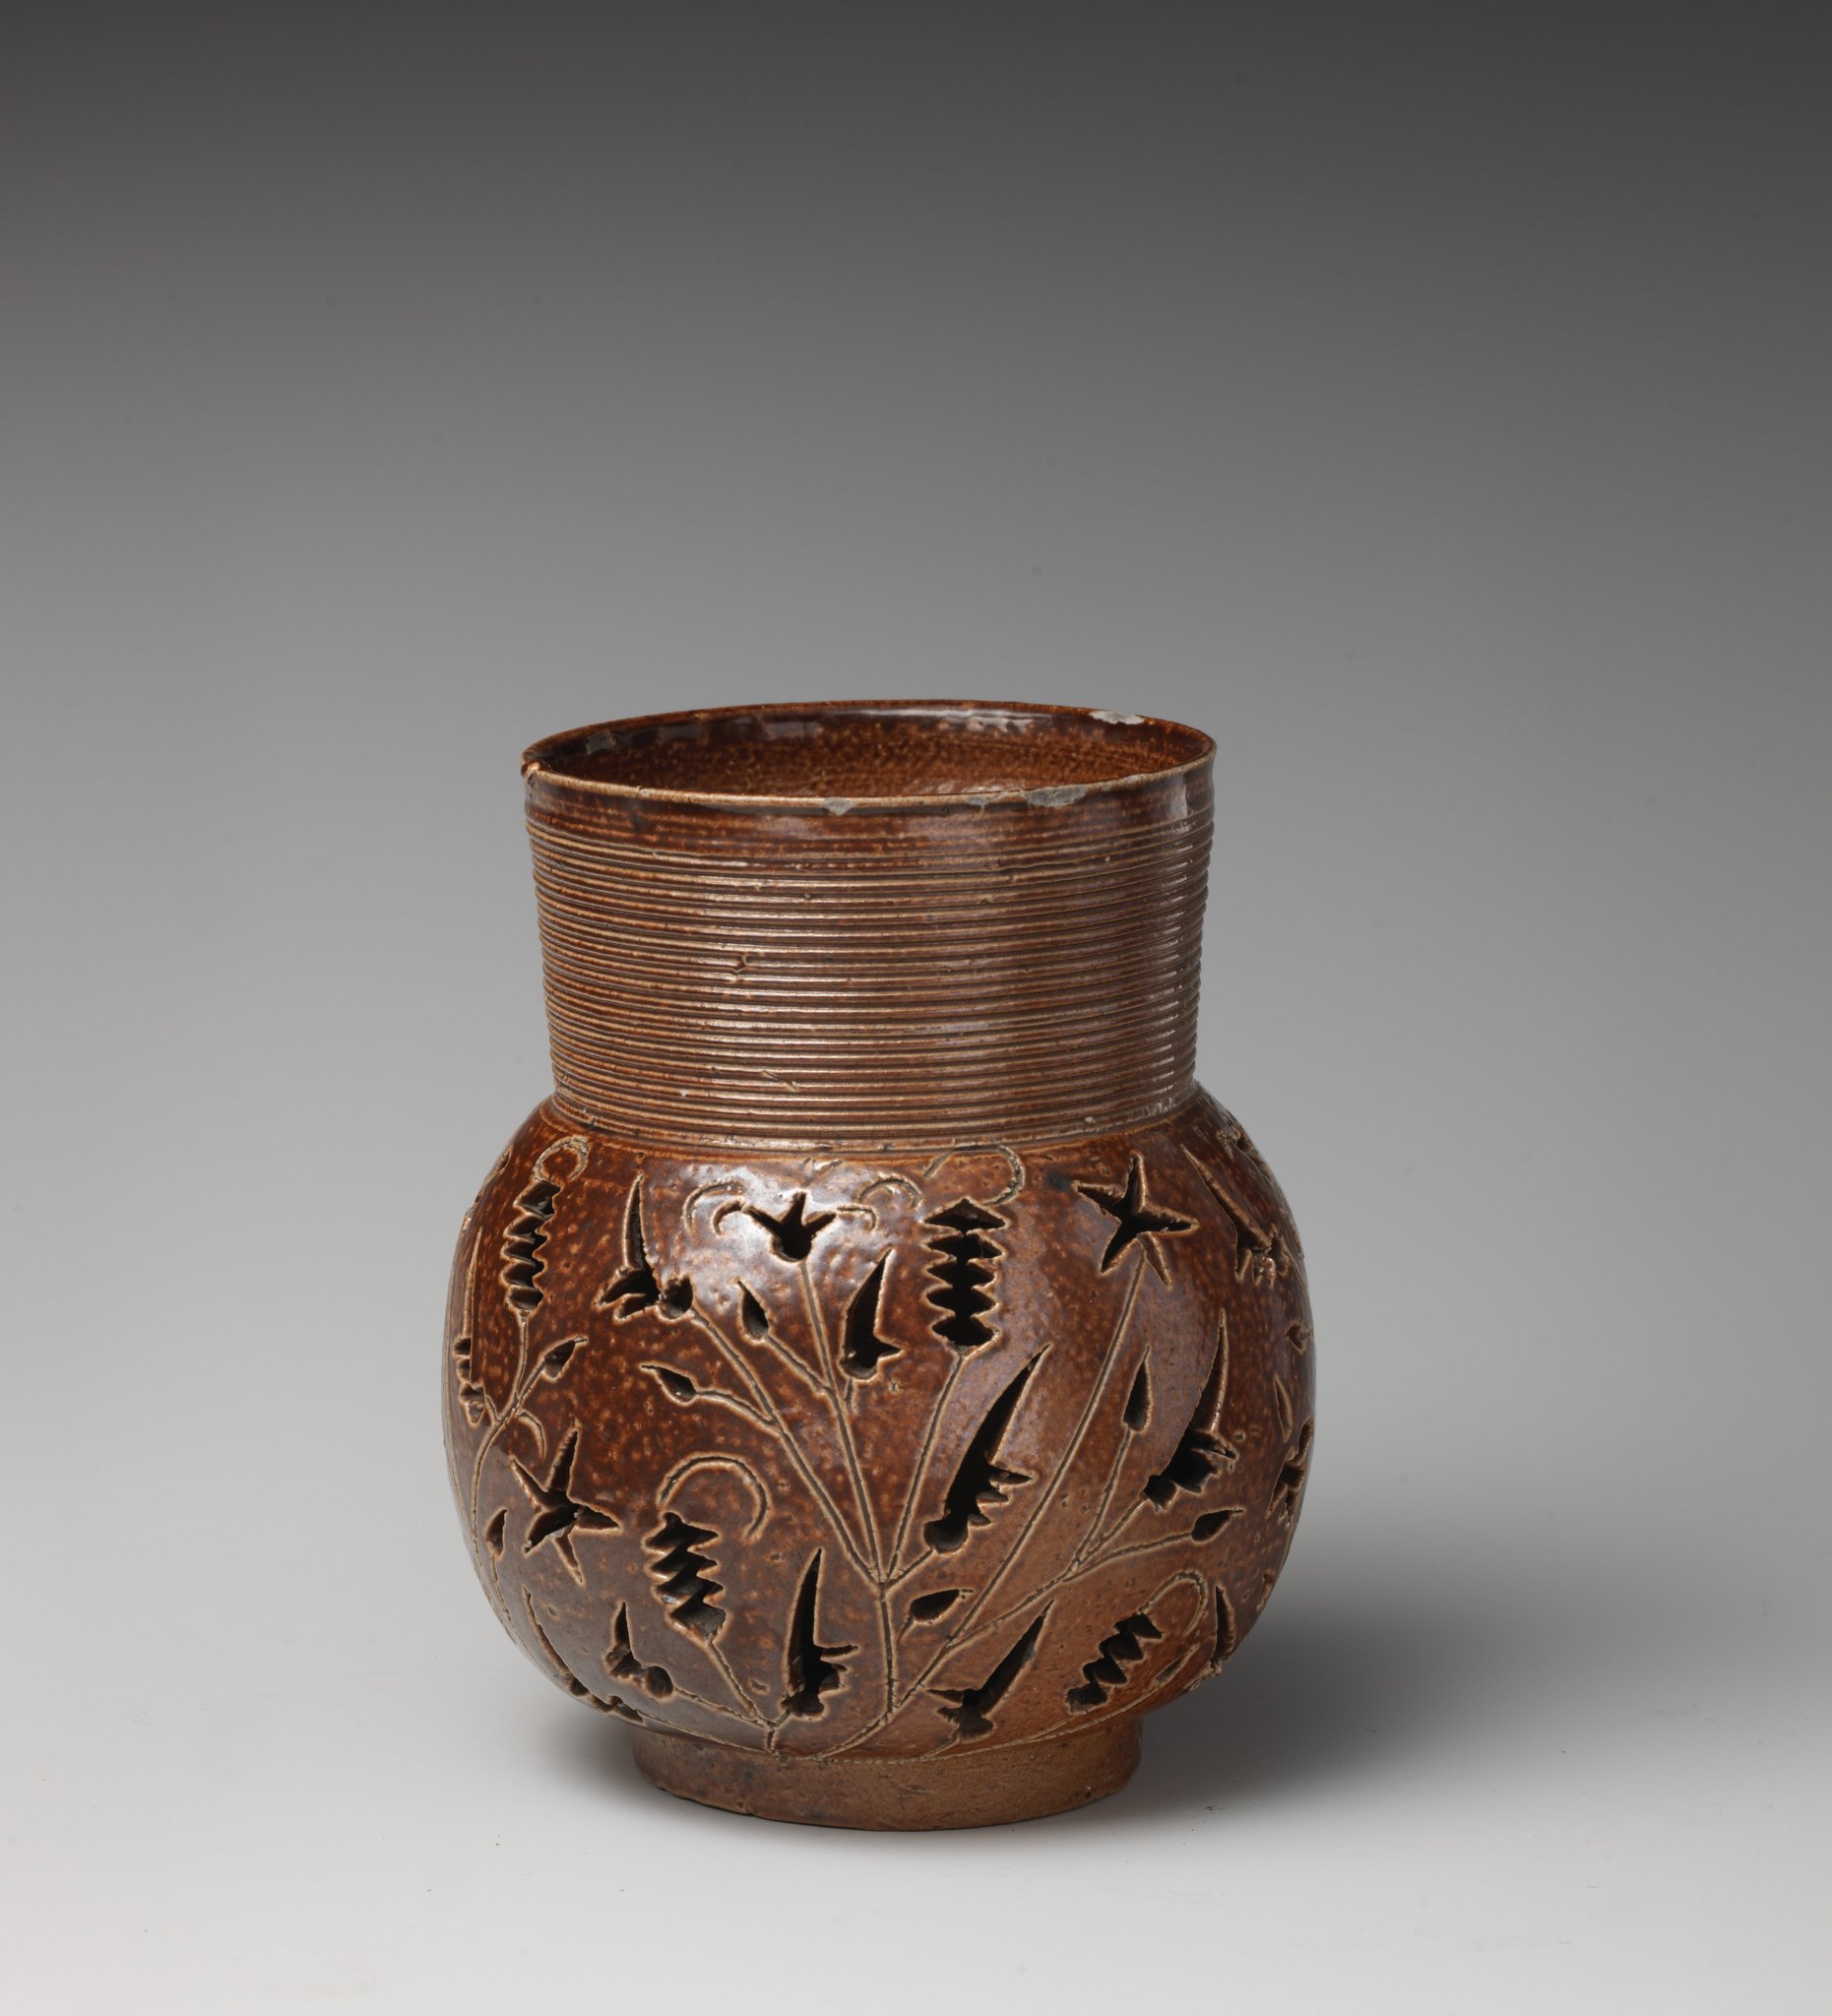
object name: tankard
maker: john dwight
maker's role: artist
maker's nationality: british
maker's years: 1635-1703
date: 1700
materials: earthenware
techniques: salt glaze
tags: flowers